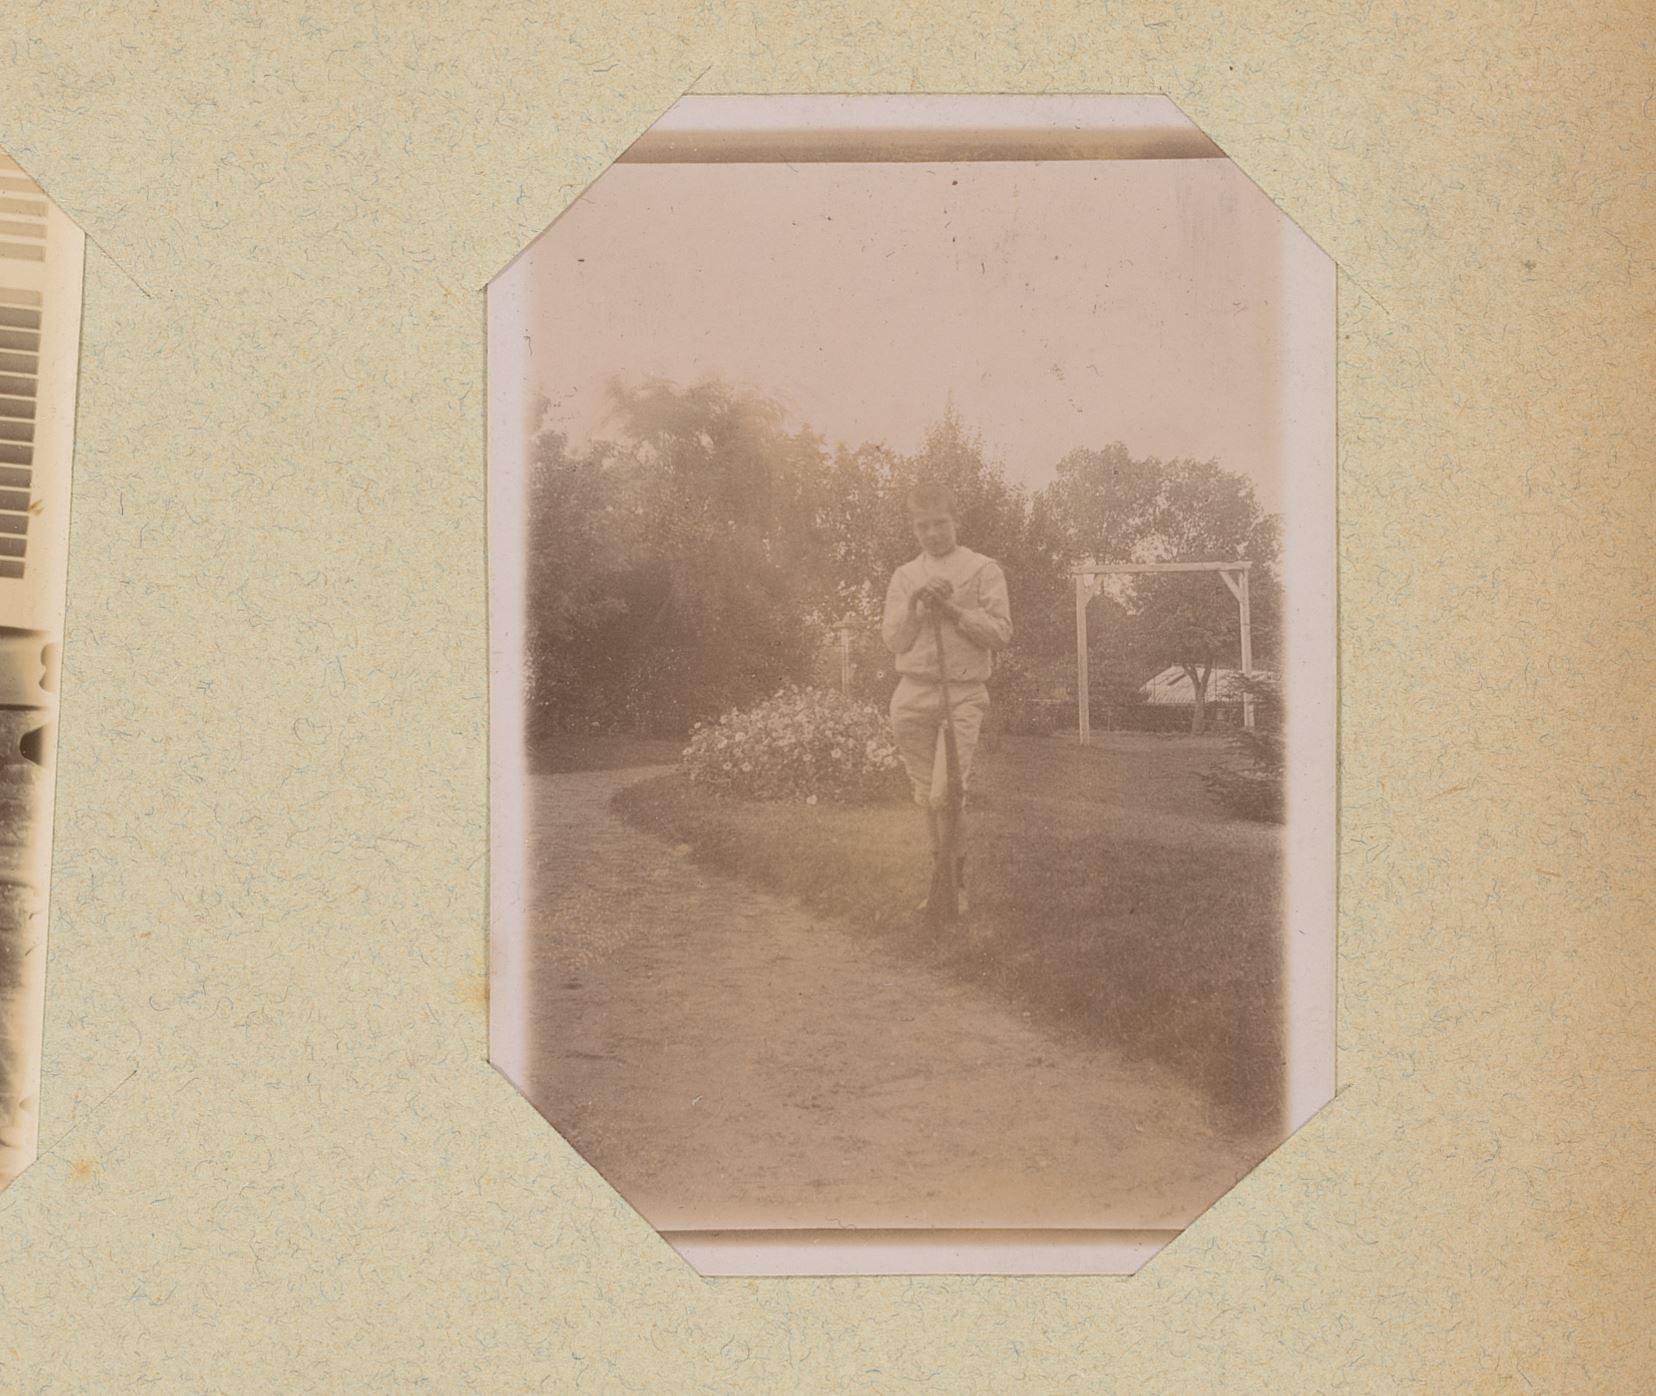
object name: album leaf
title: Portret van een jongen met een geweer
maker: Anonymous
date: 1897-1900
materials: paper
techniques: gelatin silver print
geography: france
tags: boy (child between toddler and youth), historical persons, firearms: rifle, france